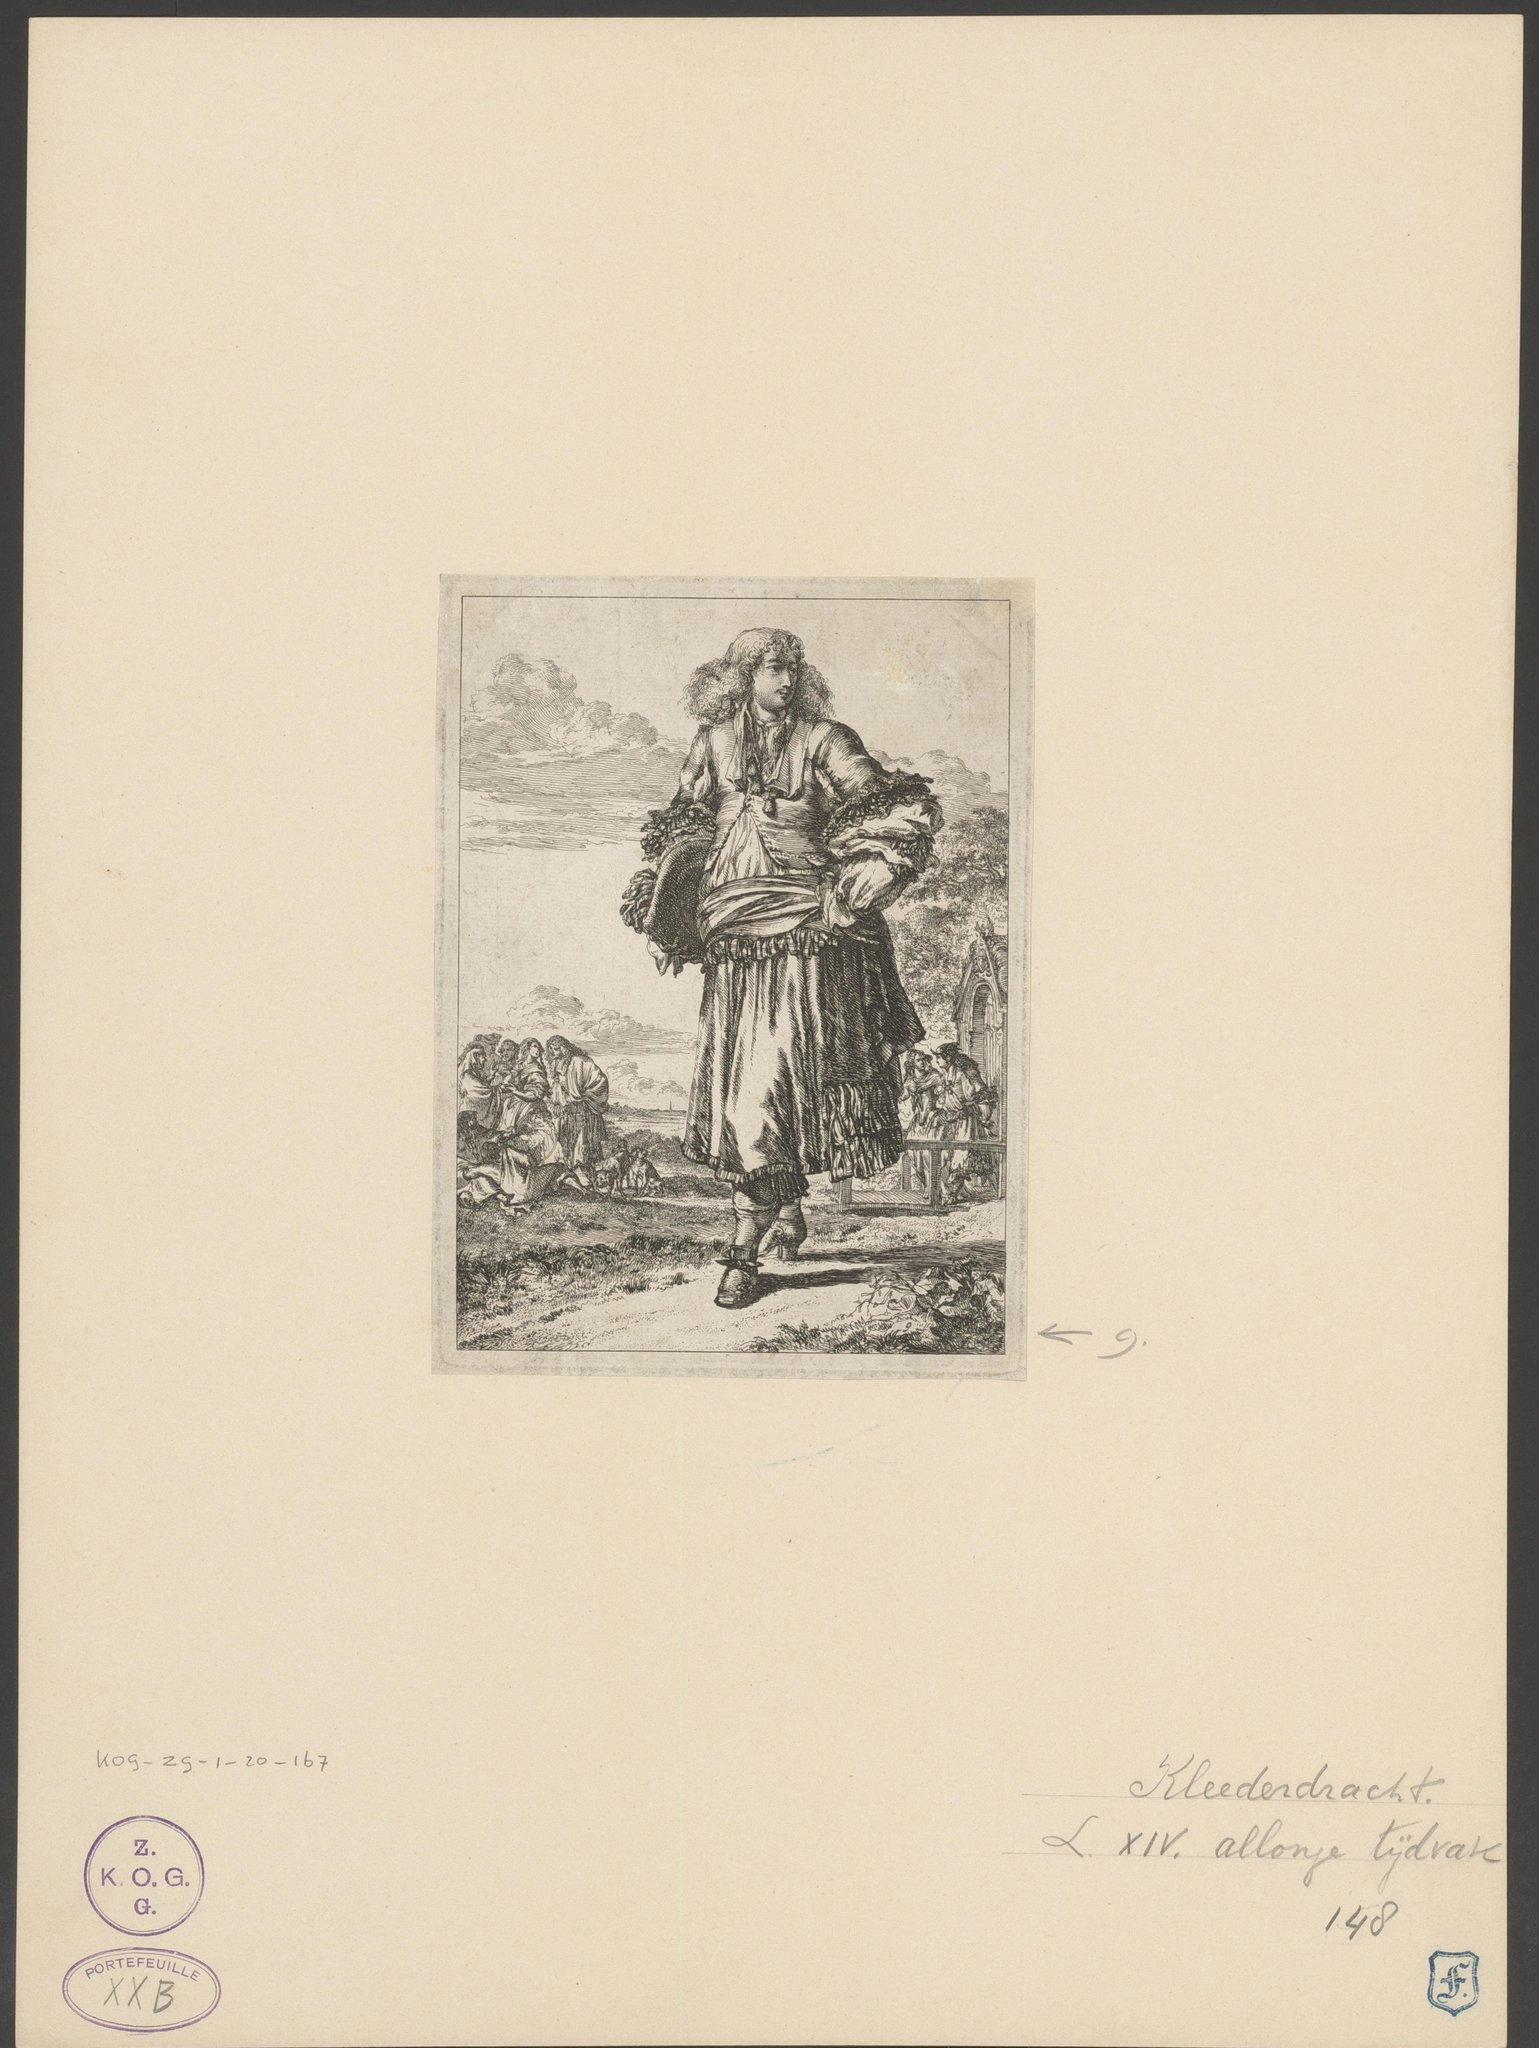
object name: print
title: Figures à la mode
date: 1662-1702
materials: paper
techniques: etching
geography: amsterdam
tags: neck-gear ~ clothing (neckerchief) (+ men's clothes), clothing for the upper part of the body (with name) (+ men's clothes), border, ribbon, braid (+ men's clothes), clothing for the upper part of the body (innocent) (+ men's clothes), head-gear: hat (+ men's clothes), styles of hairdress, fashion plates, shoes, sandals (+ men's clothes), clothes, costume (+ men's clothes), trousers, breeches, etc. (petticoat breeches) (+ men's clothes)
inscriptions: collector's mark: Lugt 963, stamp, collector's mark: Lugt 1641, collector's mark: Lugt 963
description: Man in rhingrave of wijde broekrok, die is versierd met een schort van linten en lussen, onder een innocent (kort wambuis). De hoed met veren wordt onder de arm gedragen. Op de achtergrond mannen en vrouwen voor een huis. Rechtsonder genummerd: 9. Onderwerpsrubrieken binnen de Atlas Zeden en Gewoonten: Zeden en Gewoonten in Engeren Zin, De Kleeding, Kleederdrachten (tijdvakken), Lodewijk XIV (1650 – 1720). Het allonge tijdvak).